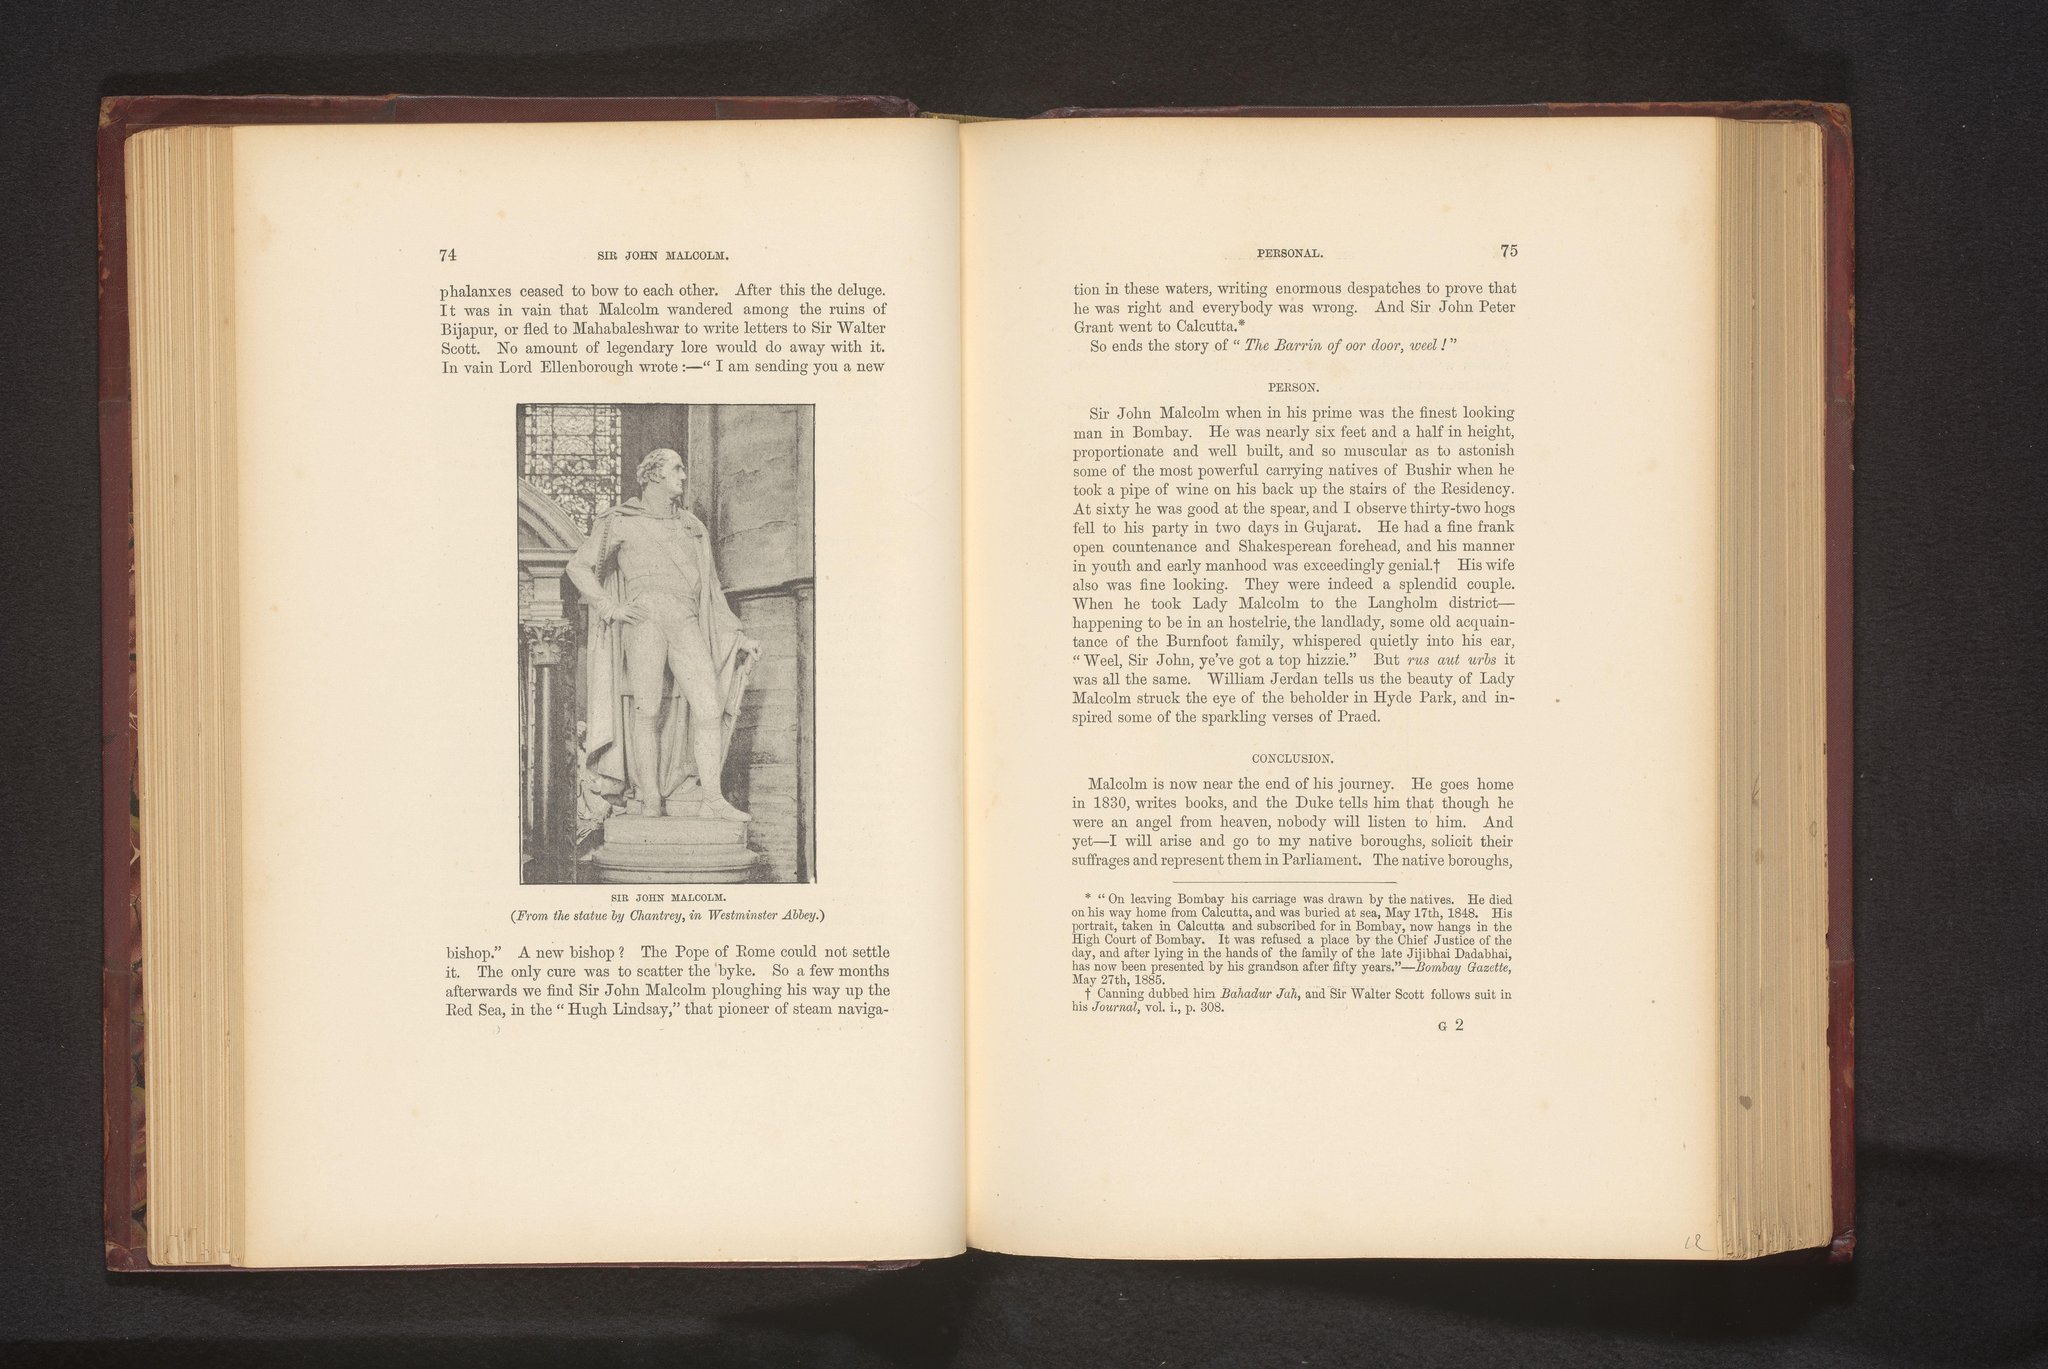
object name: photomechanical print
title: Sir John Malcolm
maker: Anonymous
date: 1883-1893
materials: paper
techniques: autotype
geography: paris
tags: interior of church, sculpture